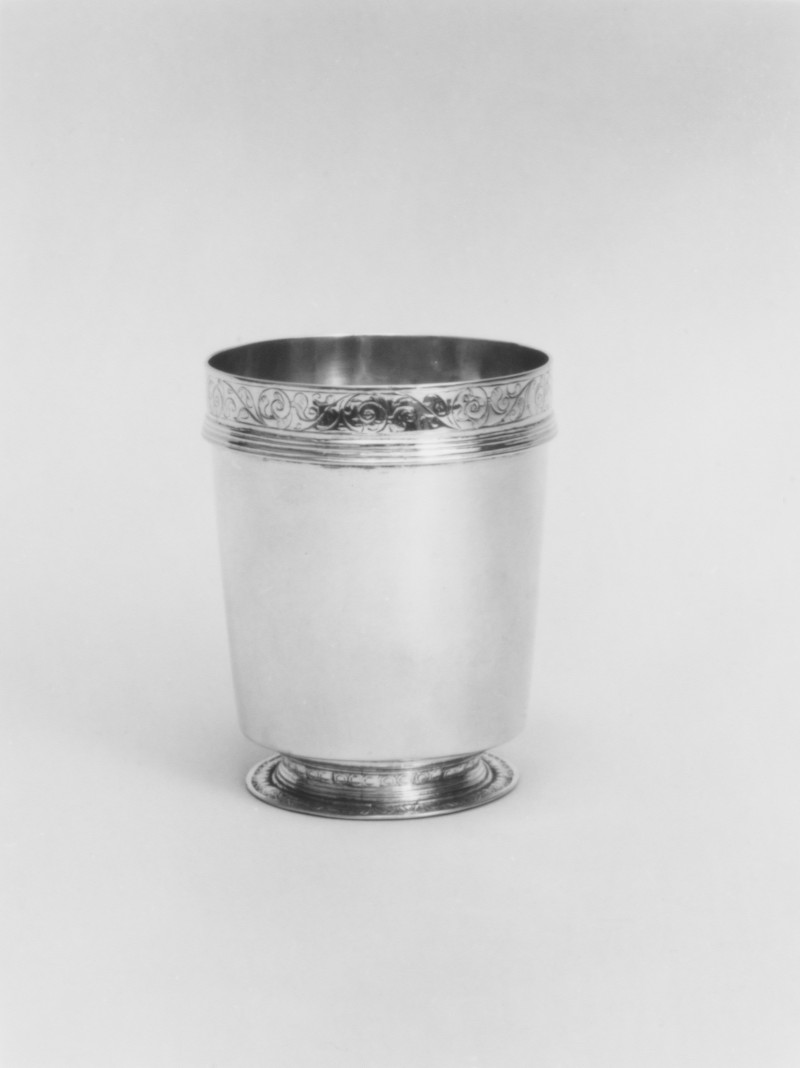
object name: beaker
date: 1579-1580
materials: silver